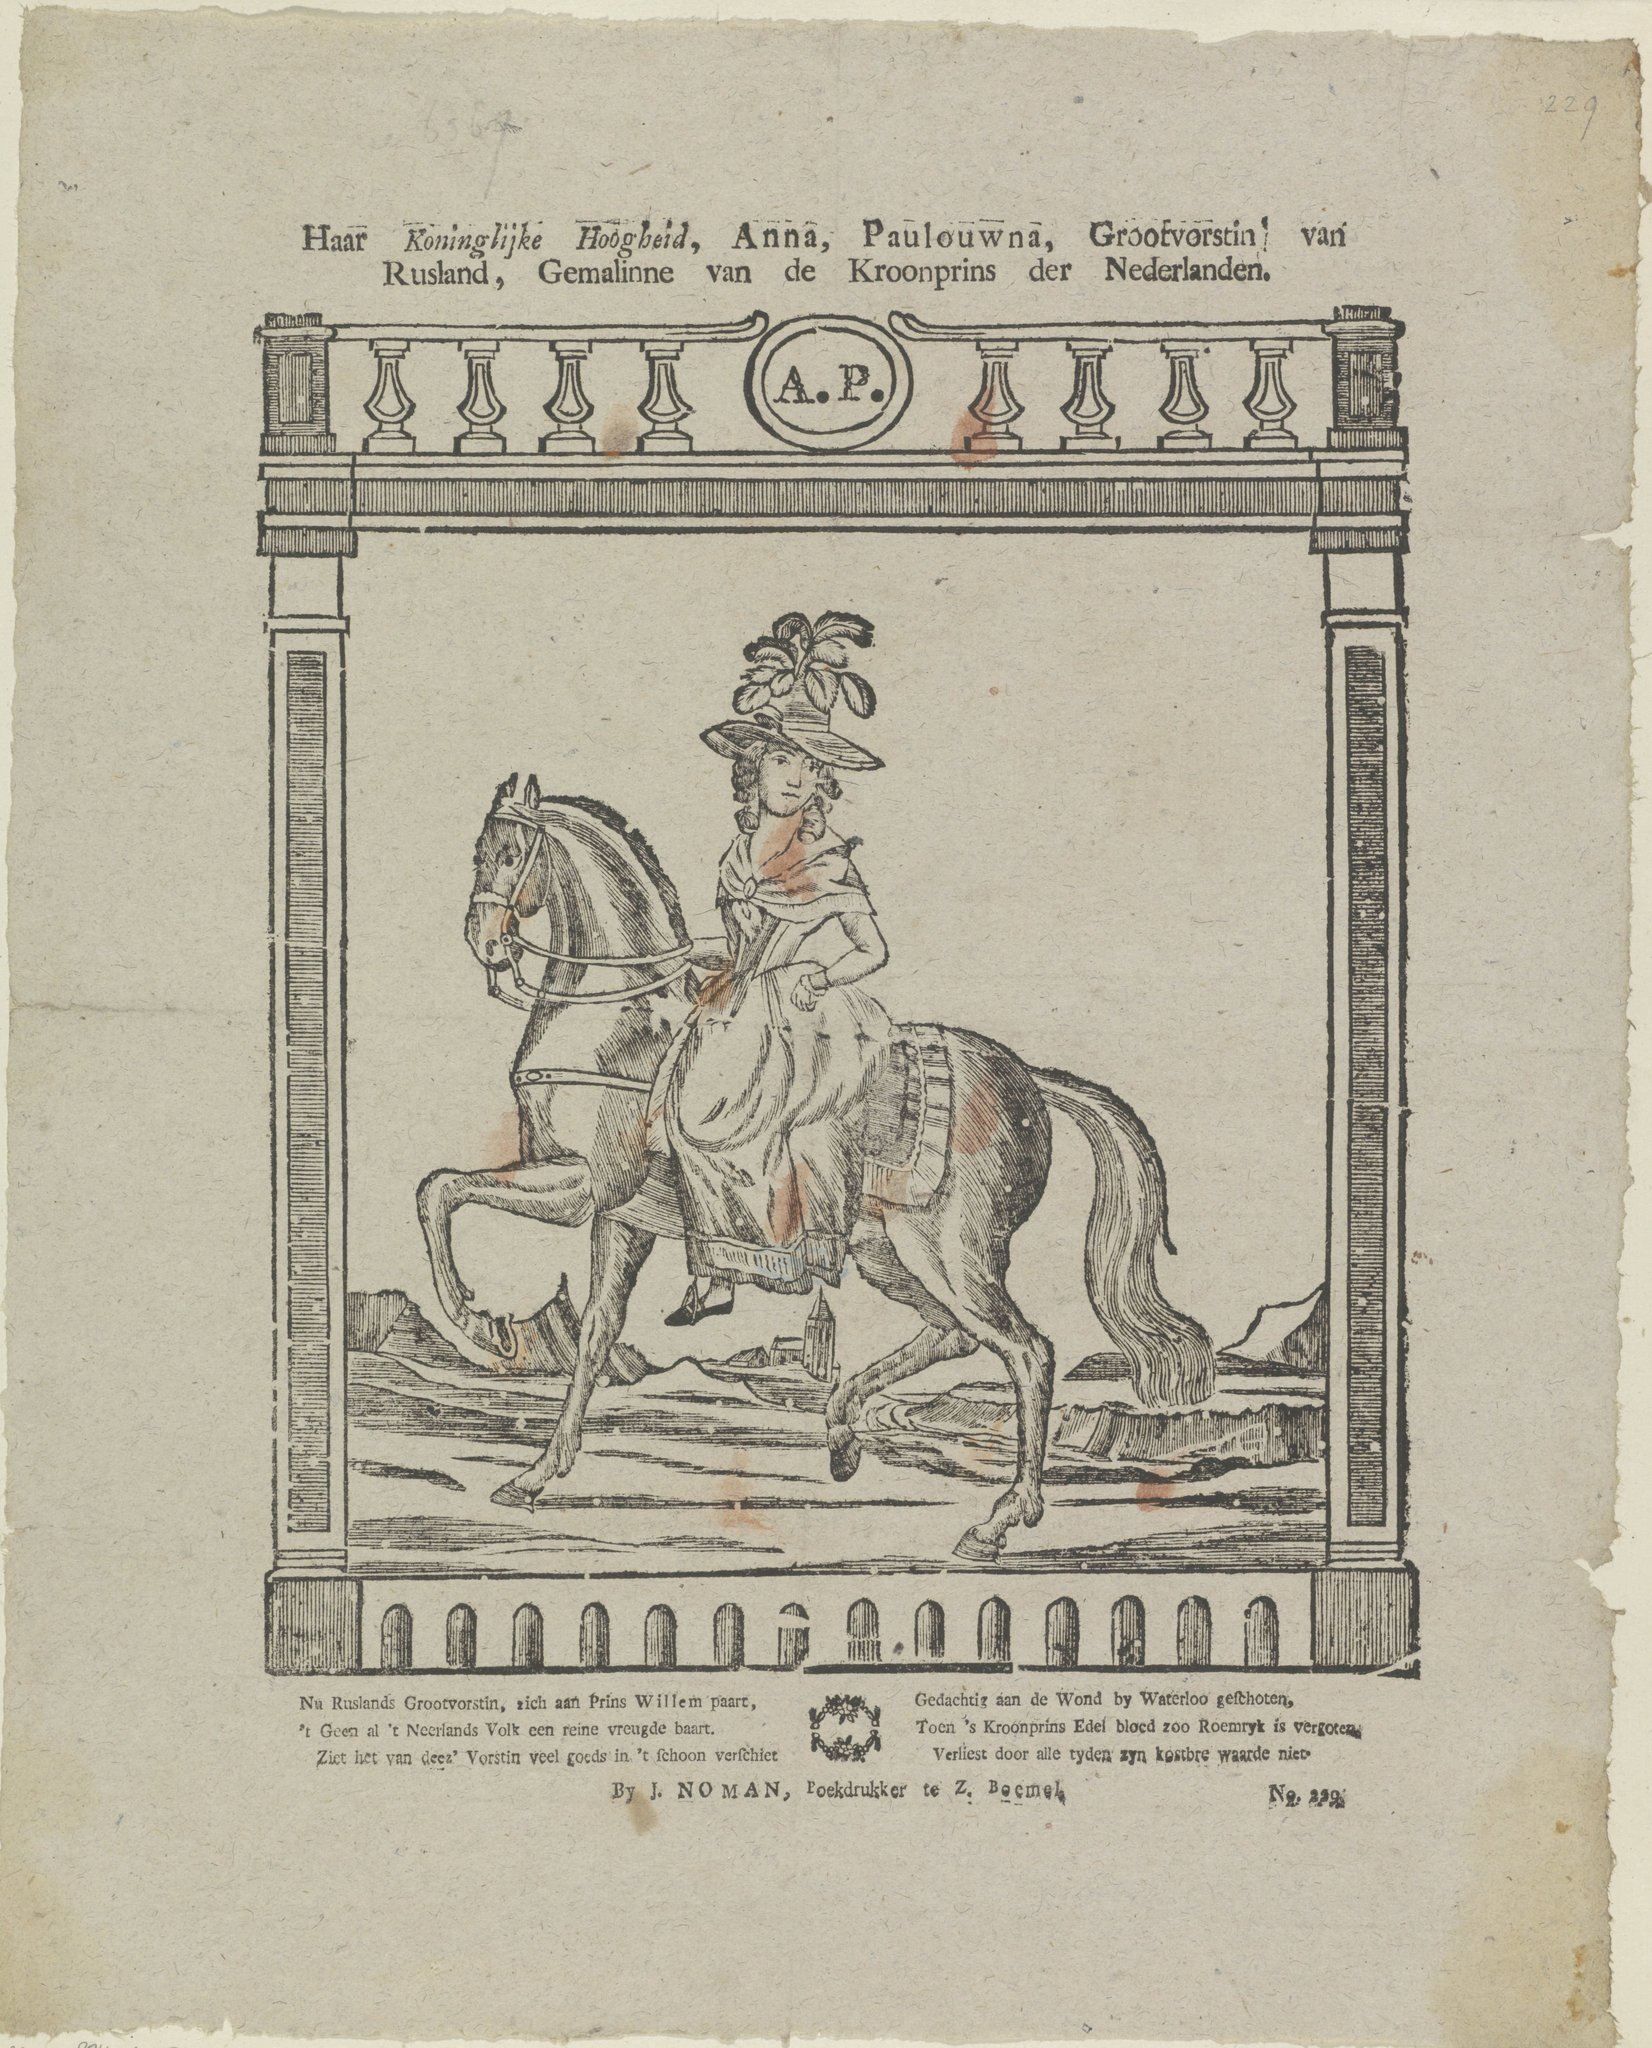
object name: popular print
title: Haar Koninglijke Hoogheid, Anna, Paulowna, Grootvorstin van / Rusland, Gemalinne van de Kroonprins der Nederlanden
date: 1806-1830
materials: paper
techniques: colour, letterpress printing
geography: netherlands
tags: the hague, anna paulowna romanowa, joséphine de beauharnais, equestrian state-portrait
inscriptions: collector's mark: Lugt 2228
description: Portret van Josephine (keizerin der Fransen) te paard, hier als Anna Paulowna Romanowa bedoeld. De voorstelling is gevat in een sierlijst, met aan de bovenzijde een balustrade. Onder de afbeelding een vers in twee kolommen. Genummerd rechtsonder: No. 229.